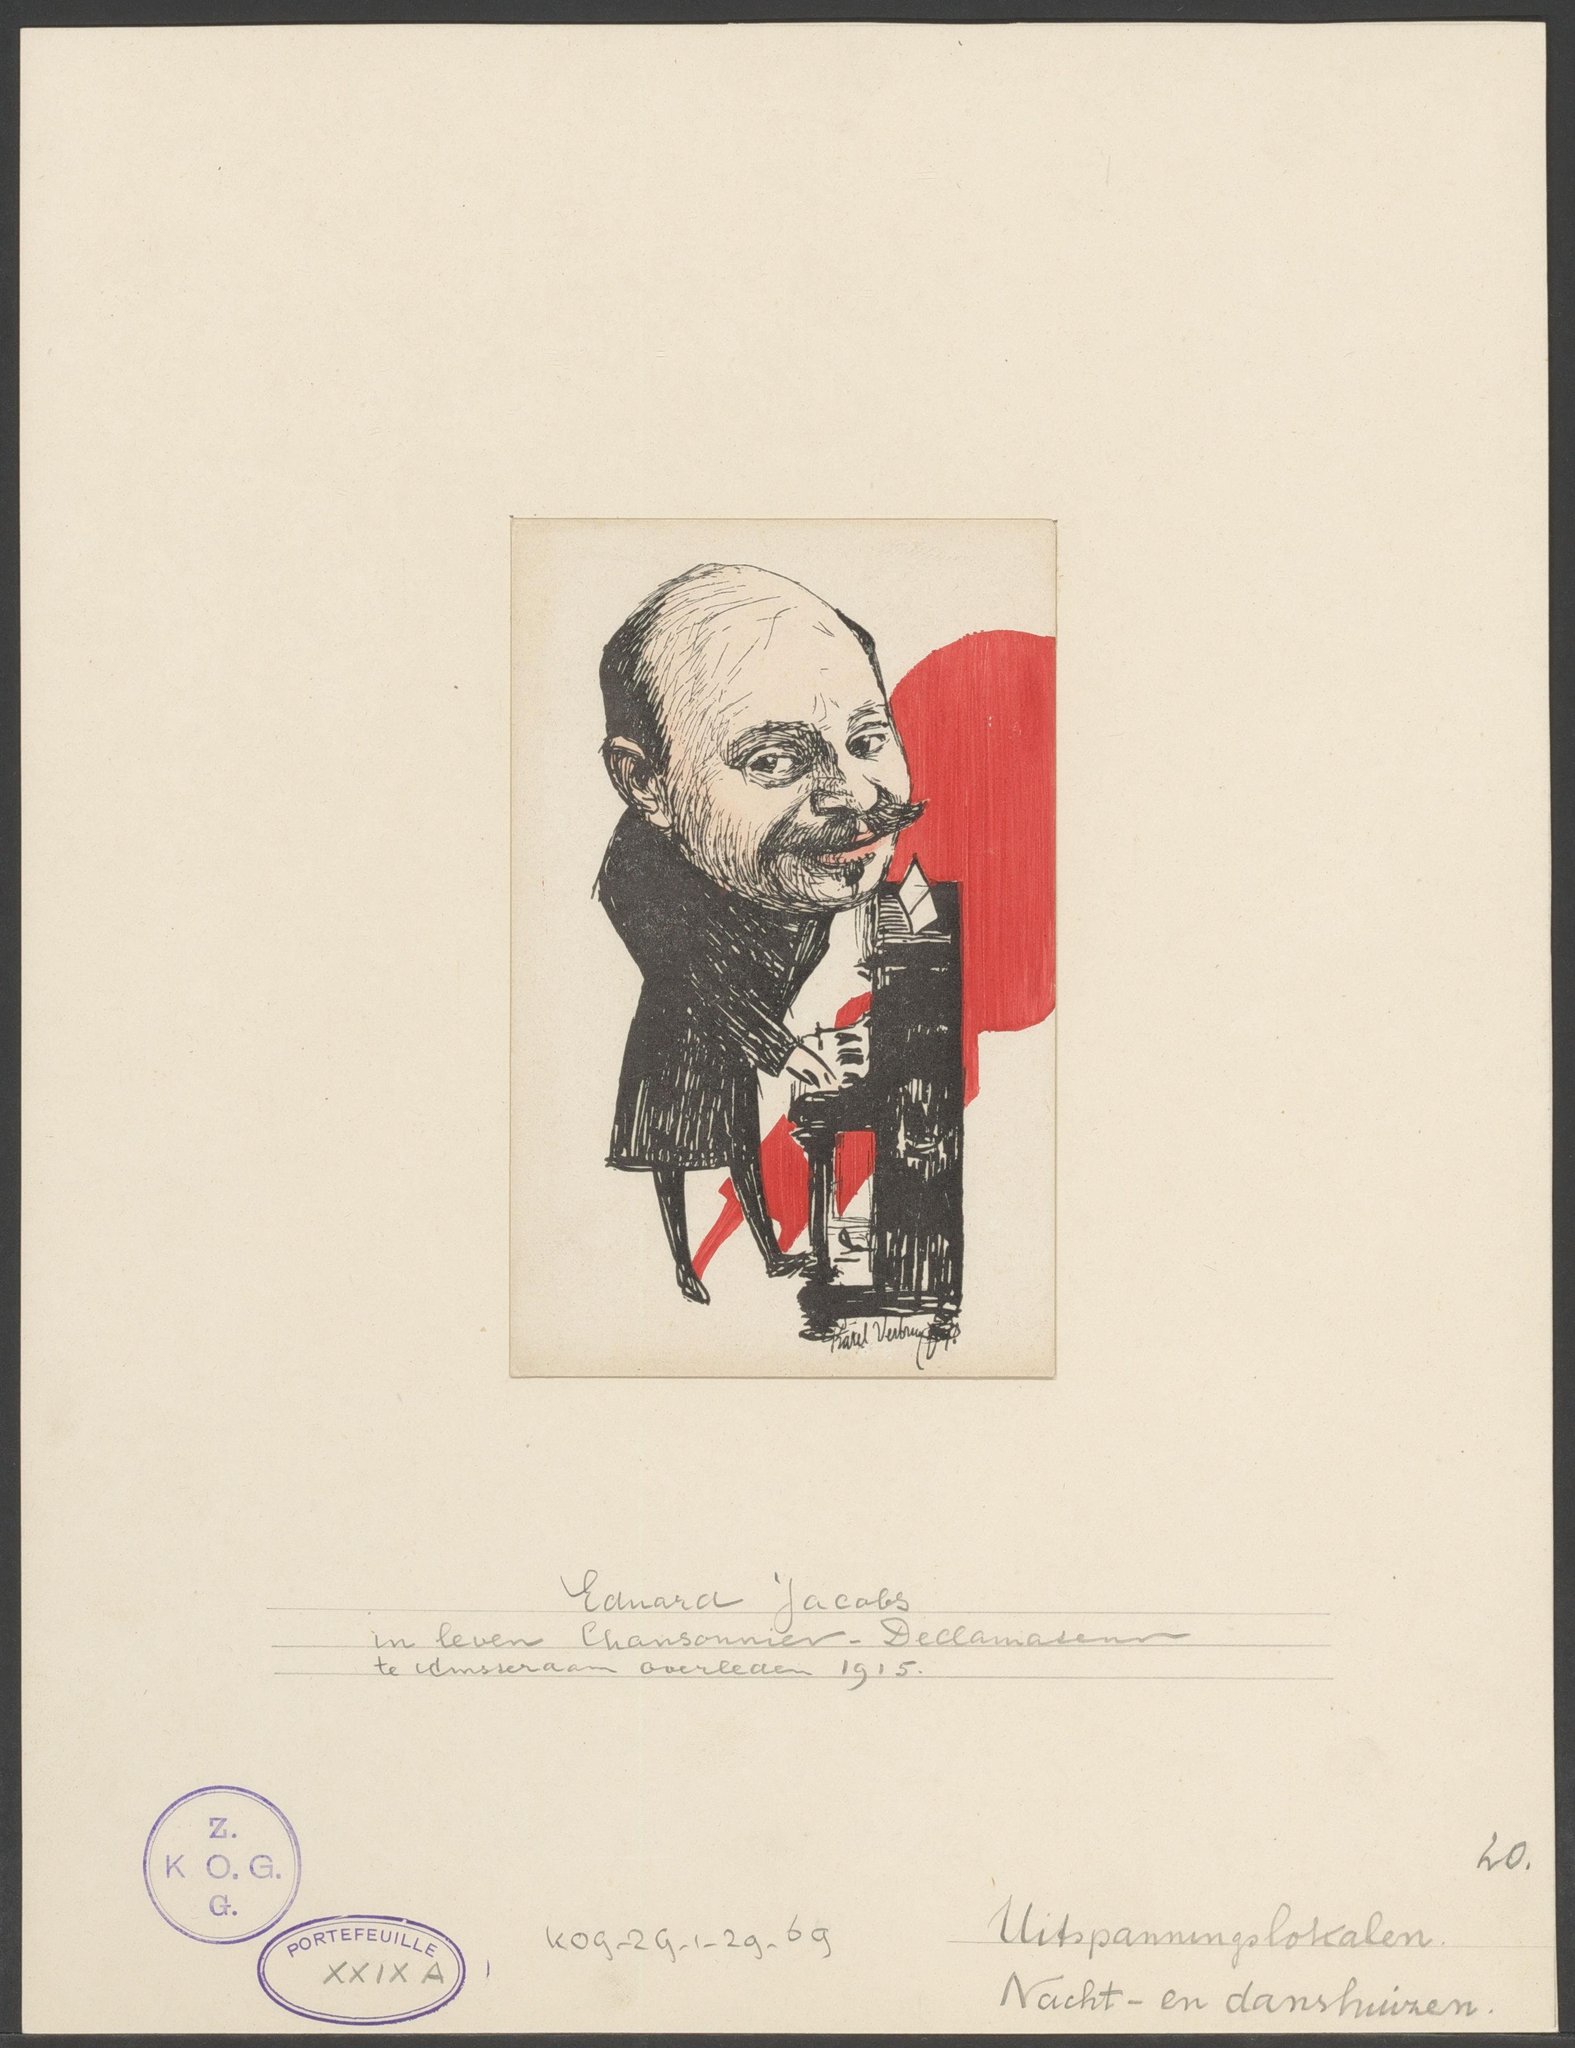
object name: ansichtkaart, prentbriefkaart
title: Karikatuur van Eduard Jacobs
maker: karel verbruggen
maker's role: draughtsman, print maker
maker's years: 1871-1931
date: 1905-1915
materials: paper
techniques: line block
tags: amsterdam, painter, sculptor, historical persons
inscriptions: collector's mark: Lugt 1641, stamp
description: Onderwerpsrubrieken binnen de Atlas Zeden en Gewoonten: Zeden en gewoonten in engeren zin, Volksleven, Uitspanningslokalen, Het Panopticum en degelijke.